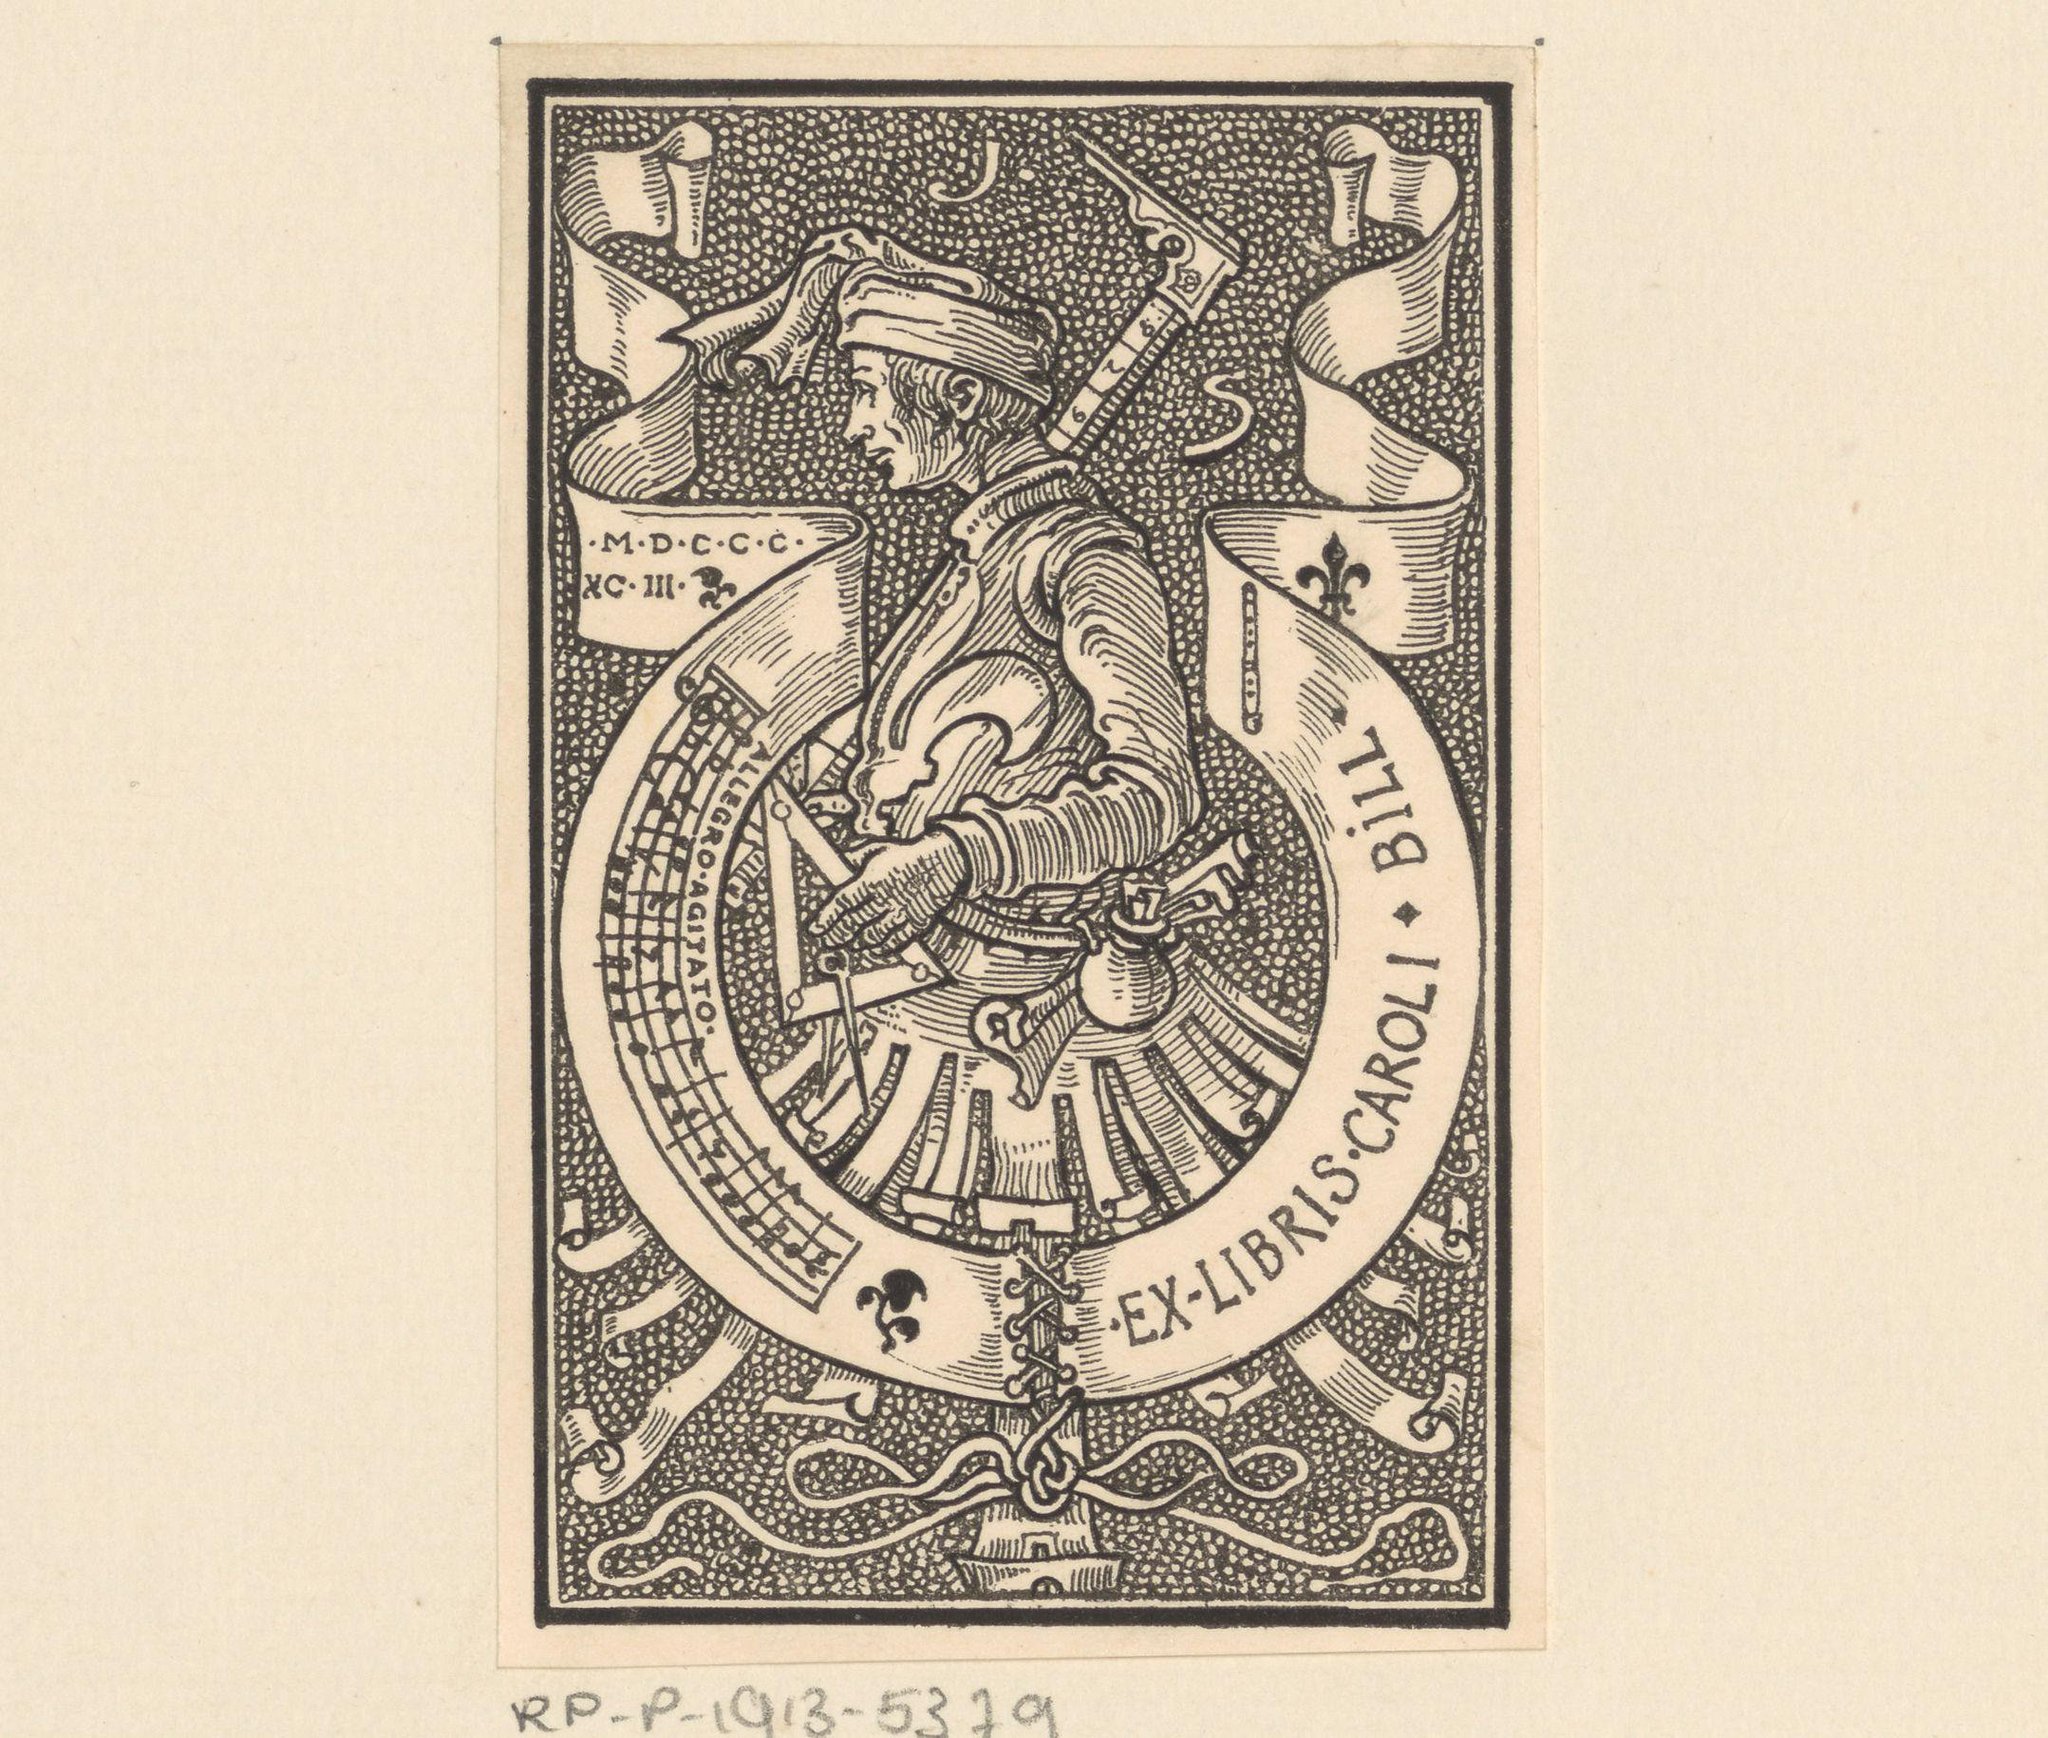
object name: bookplate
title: Ex-libris Caroli Bill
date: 1893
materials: paper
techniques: printing block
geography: germany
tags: notation of music, standing figure, historical costume, tools, implements of architect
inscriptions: collector's mark: Lugt 2760, collector's mark: Lugt 2233